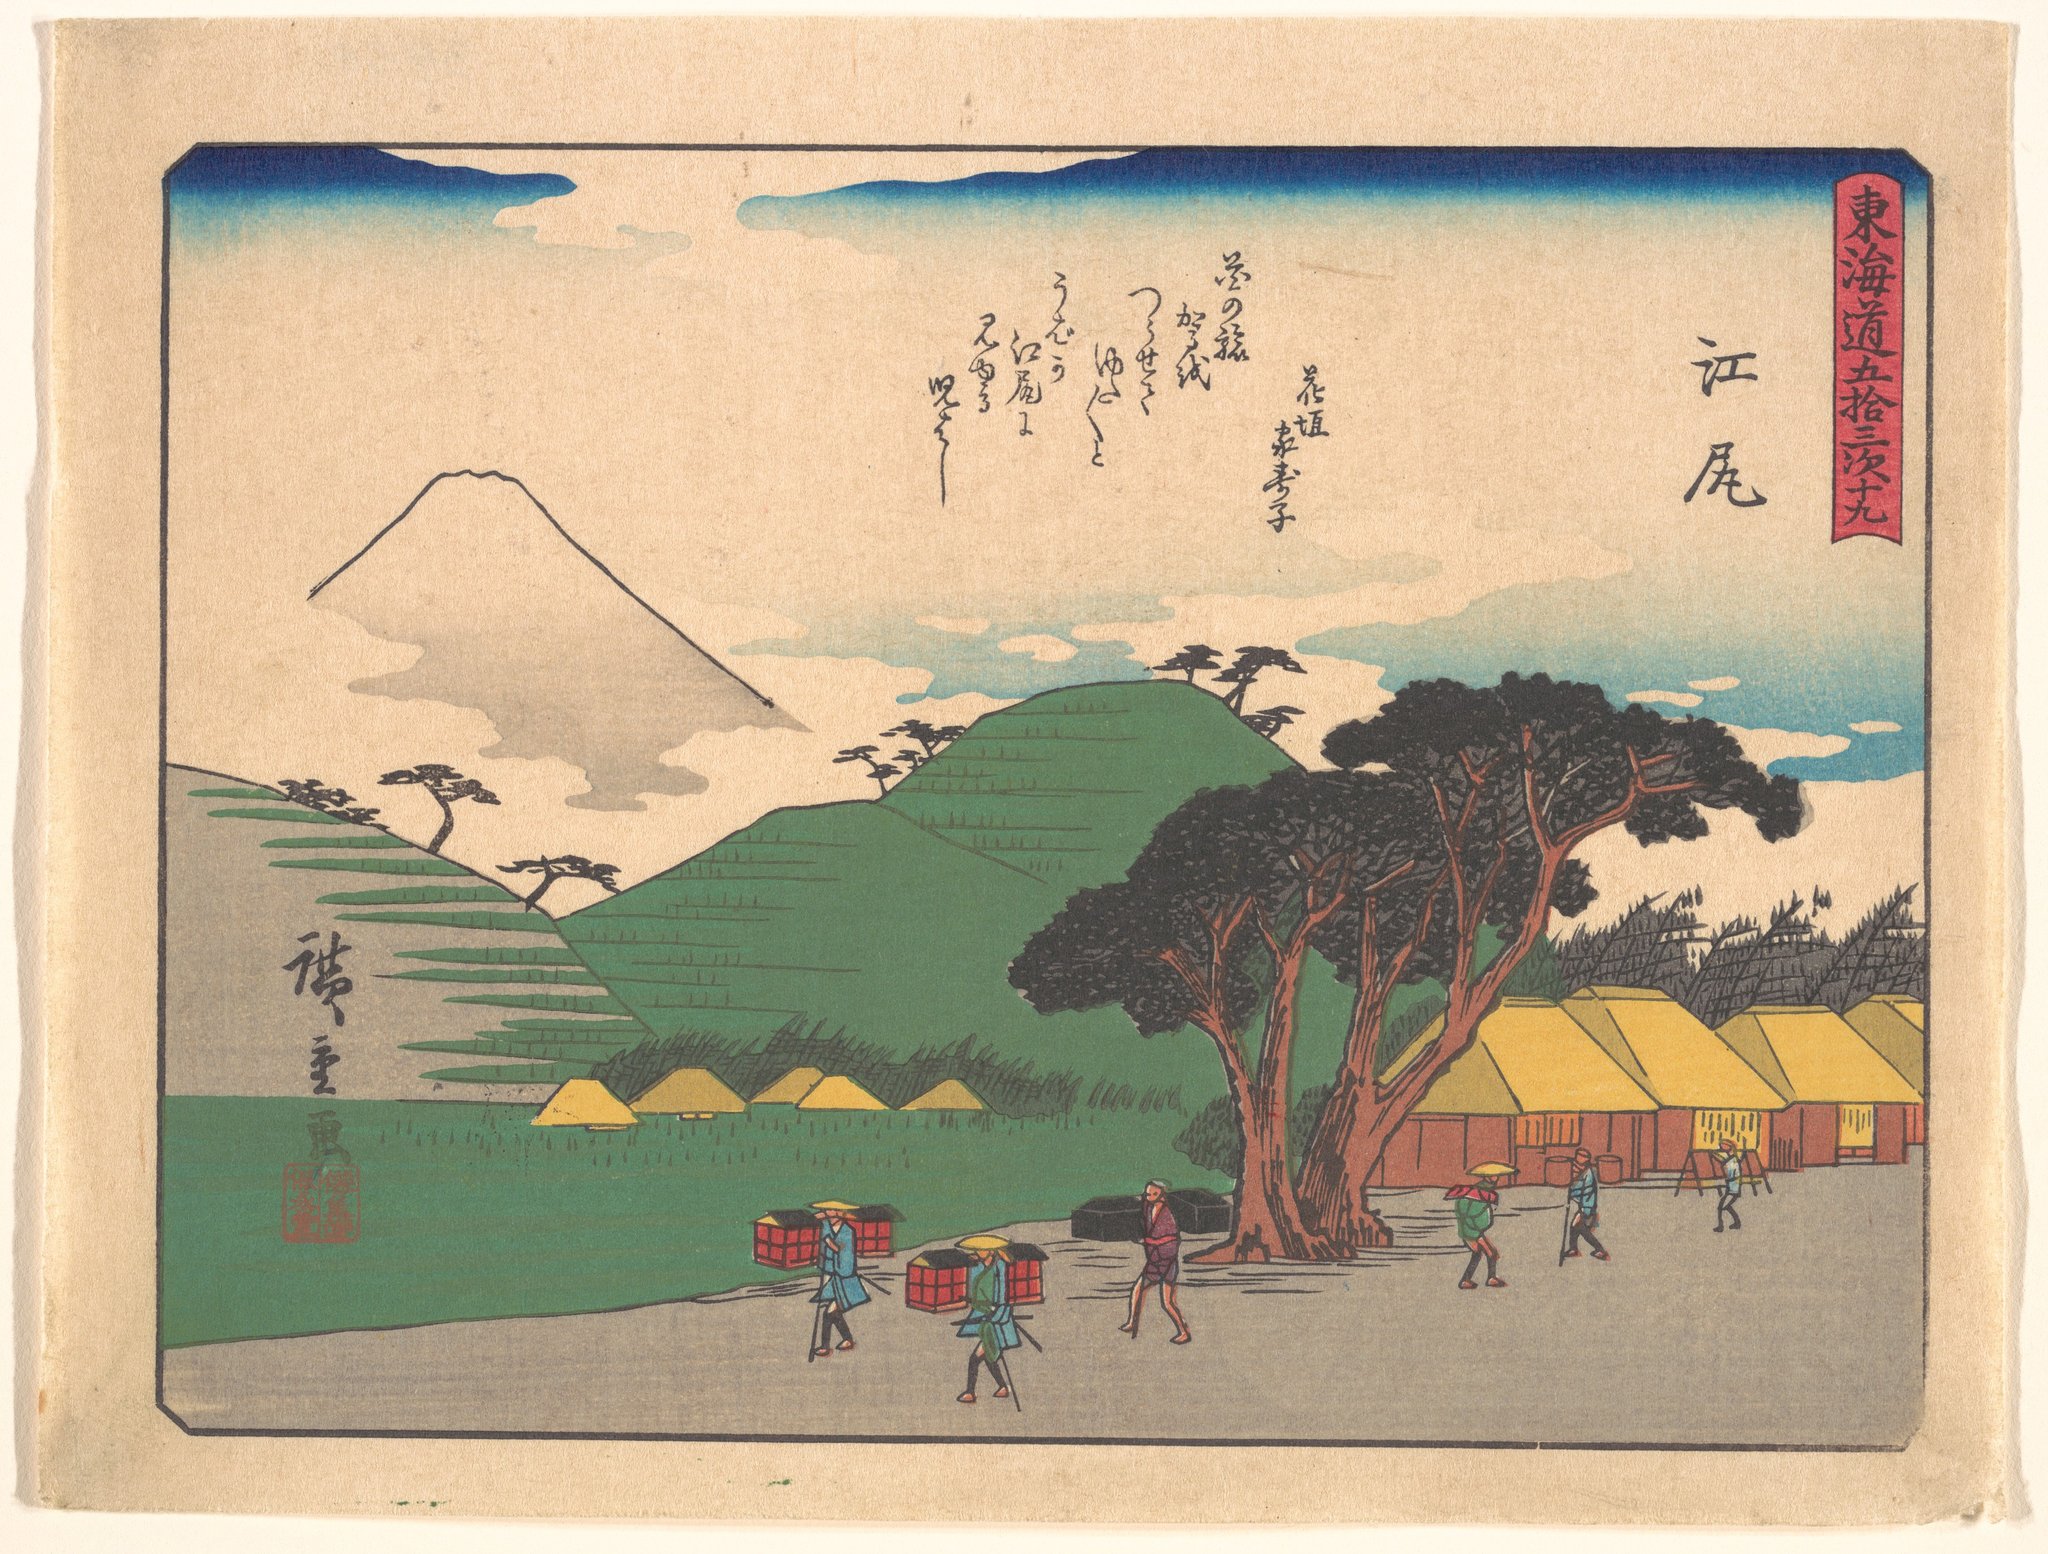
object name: print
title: 東海道五十三次 江尻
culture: japanese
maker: utagawa hiroshige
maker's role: artist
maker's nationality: japanese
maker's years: 1797-1858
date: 1901-1933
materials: ink, paper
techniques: woodblock print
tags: houses,men,mountains,landscapes,trees